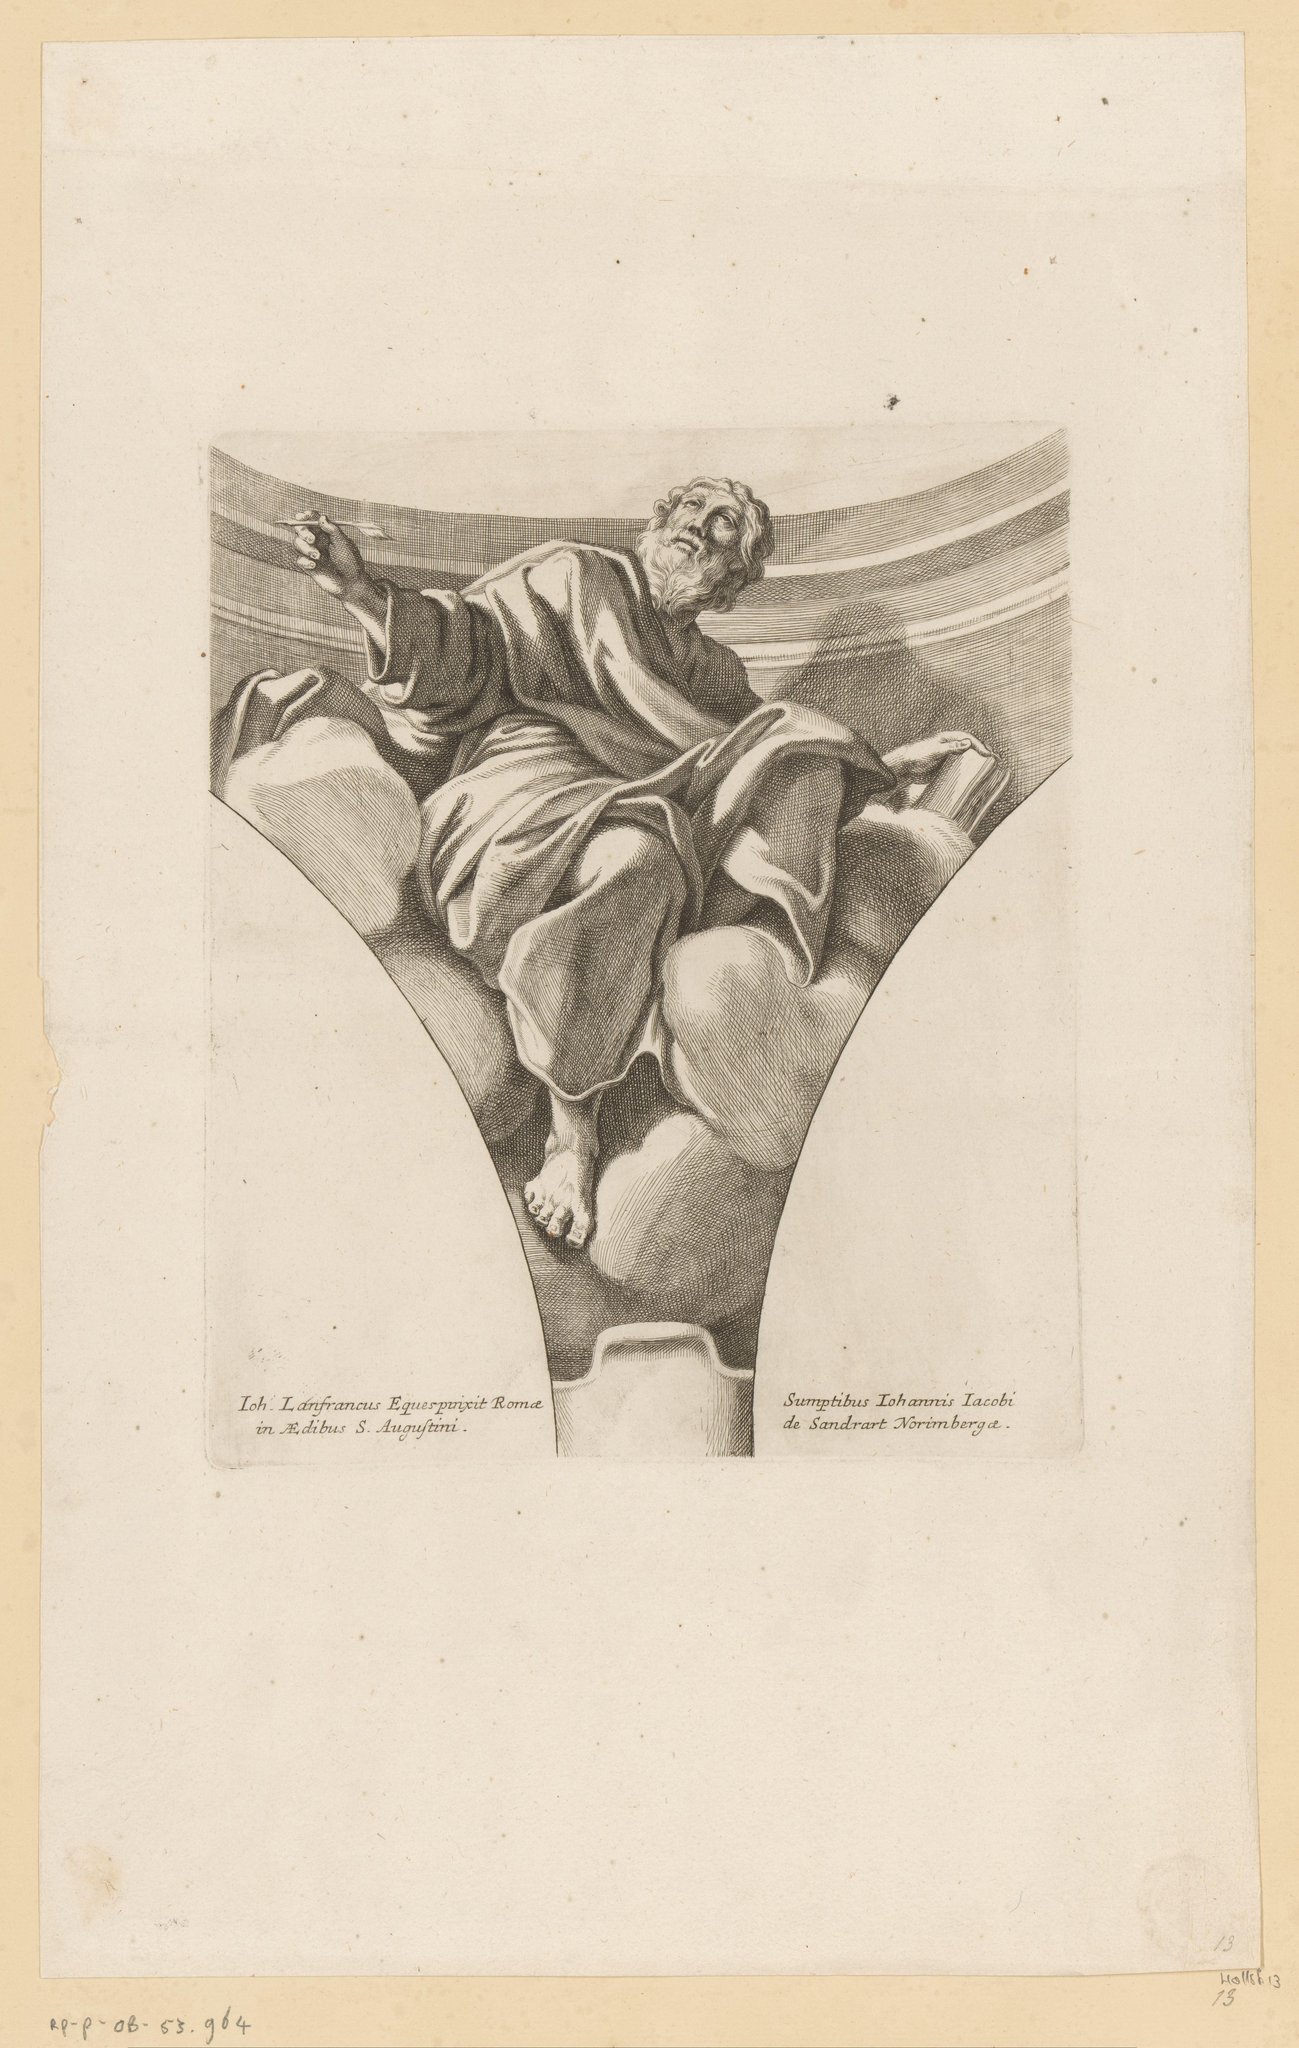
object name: print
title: Schilderijen in de Sant'Agostino in Rome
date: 1665-1698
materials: paper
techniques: etching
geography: nuremberg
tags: the four evangelists without their symbols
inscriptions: collector's mark: Lugt 240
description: Onderdeel van een serie van negen prenten naar schilderijen in de Sant'Agostino in Rome.